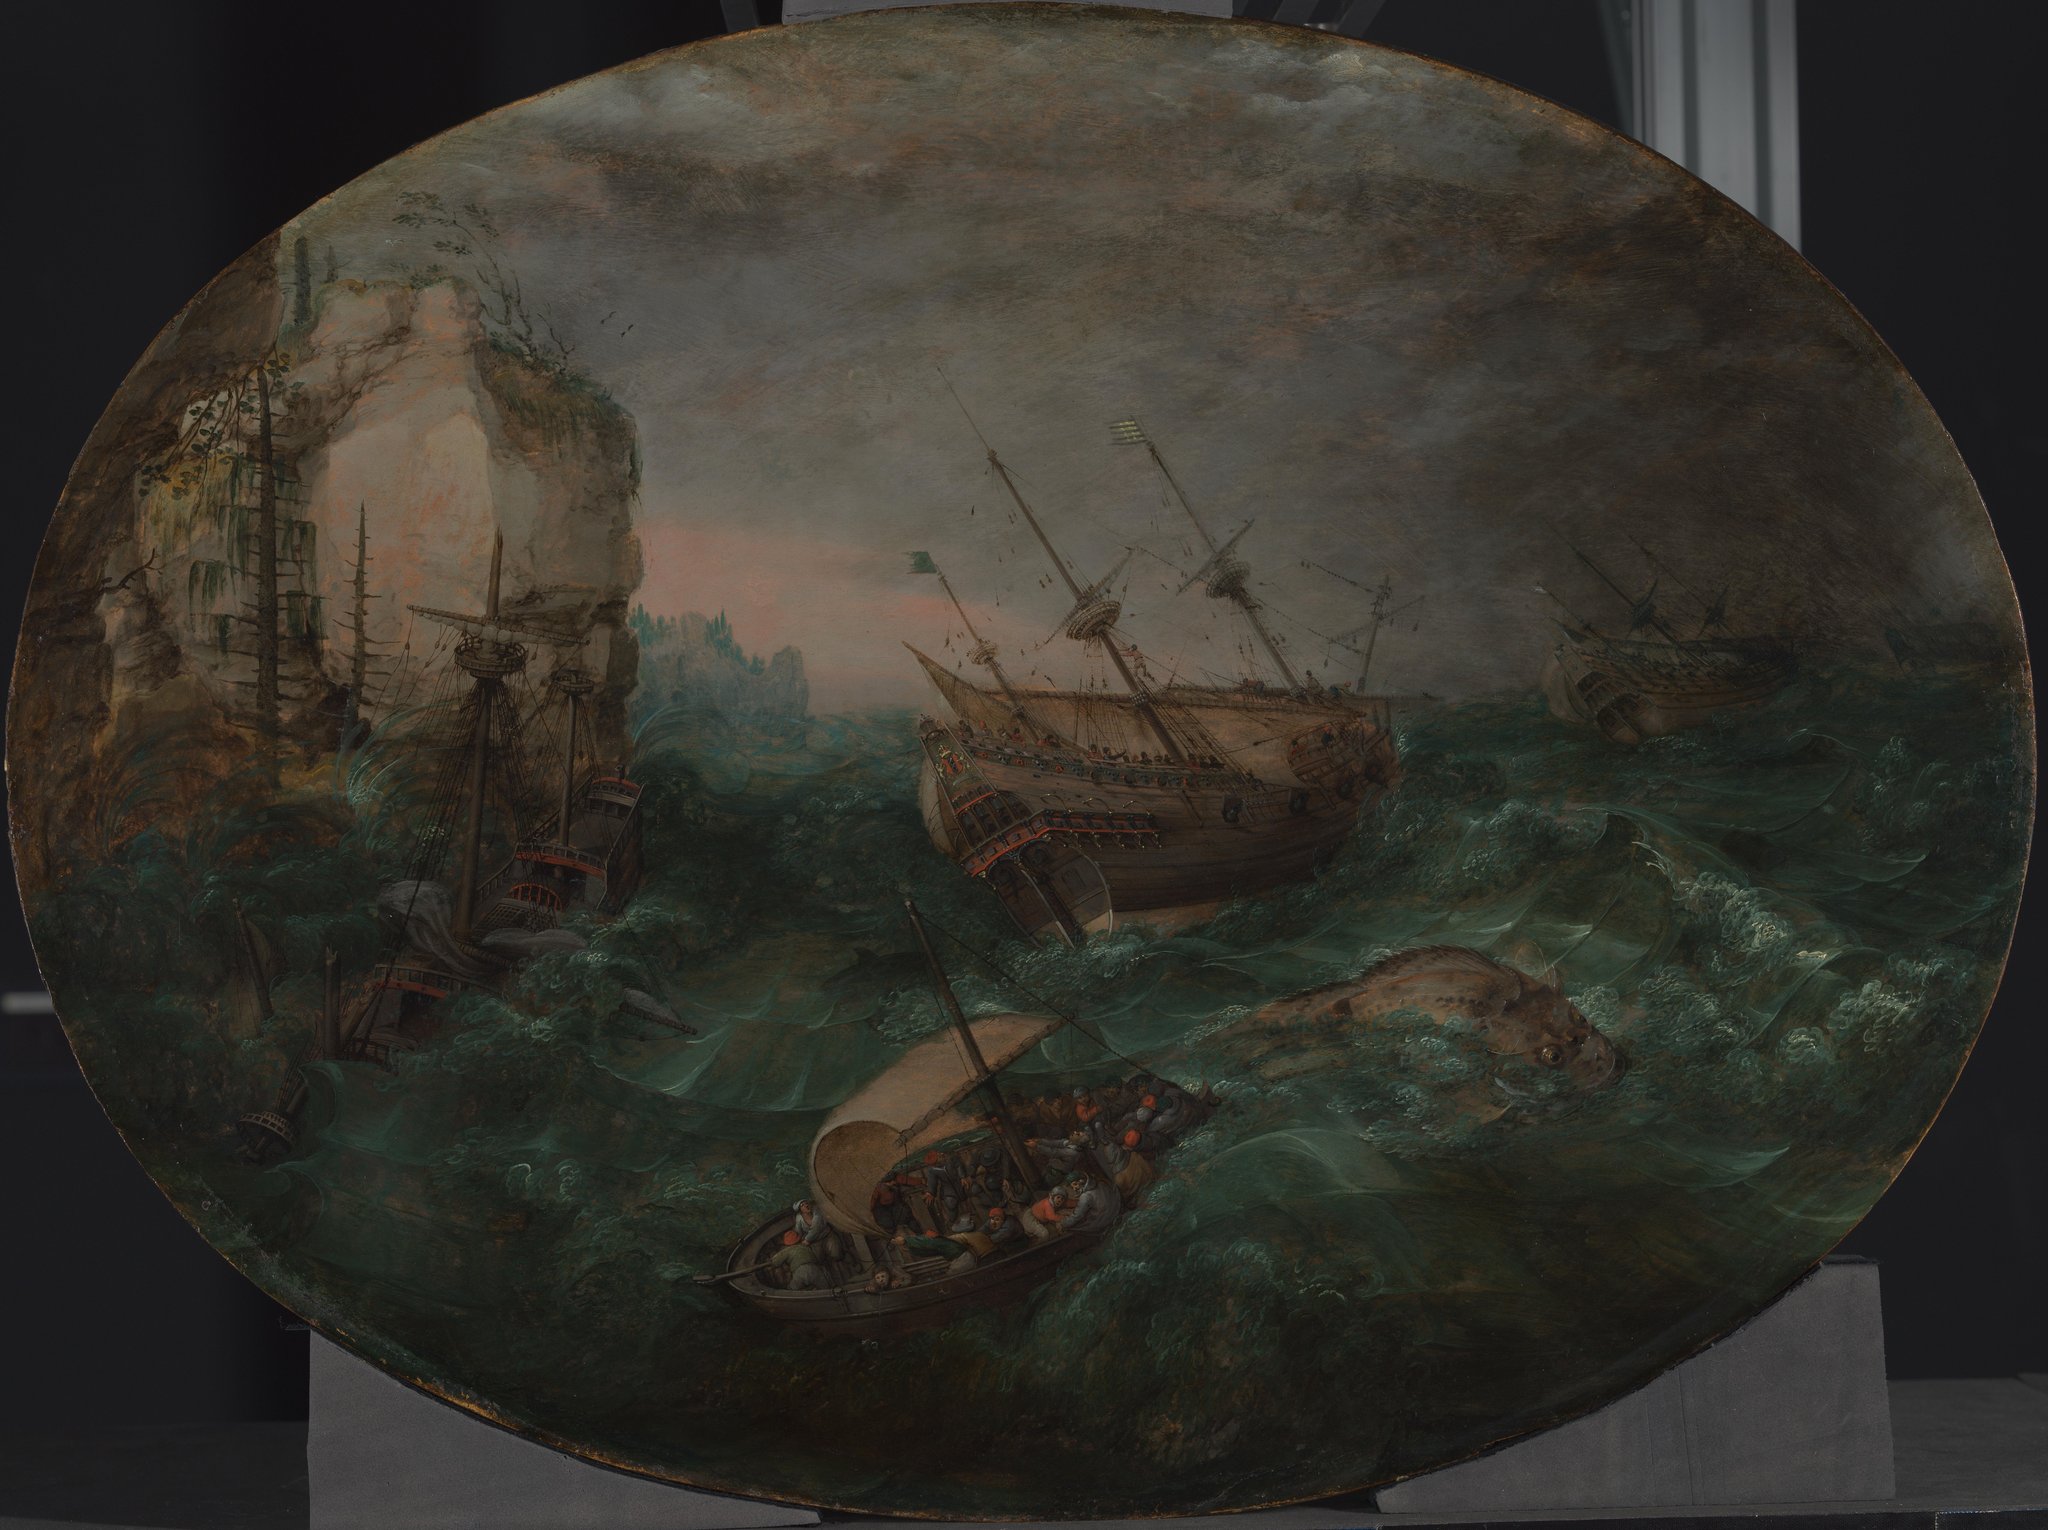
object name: painting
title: Shipwreck off a Rocky Coast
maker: adam willaerts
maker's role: painter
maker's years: 1577-1664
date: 1614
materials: oil, panel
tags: shipwreck, storm at sea, coastal cliff or crag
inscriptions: signature and date, bottom centre on the side of the lifeboat: ‘AD Wilarts fe 1614’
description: Those who went to sea played roulette with their lives. The wooden ships were small and fragile, and the very real dangers were exaggerated with horror stories of hideous creatures living in the unfathomable depths. Willaerts created an image of every seaman’s worst nightmare. One ship has been dashed on the rocks, and the other two are heeling over. The survivors at centre are threatened by a monstrous fish.